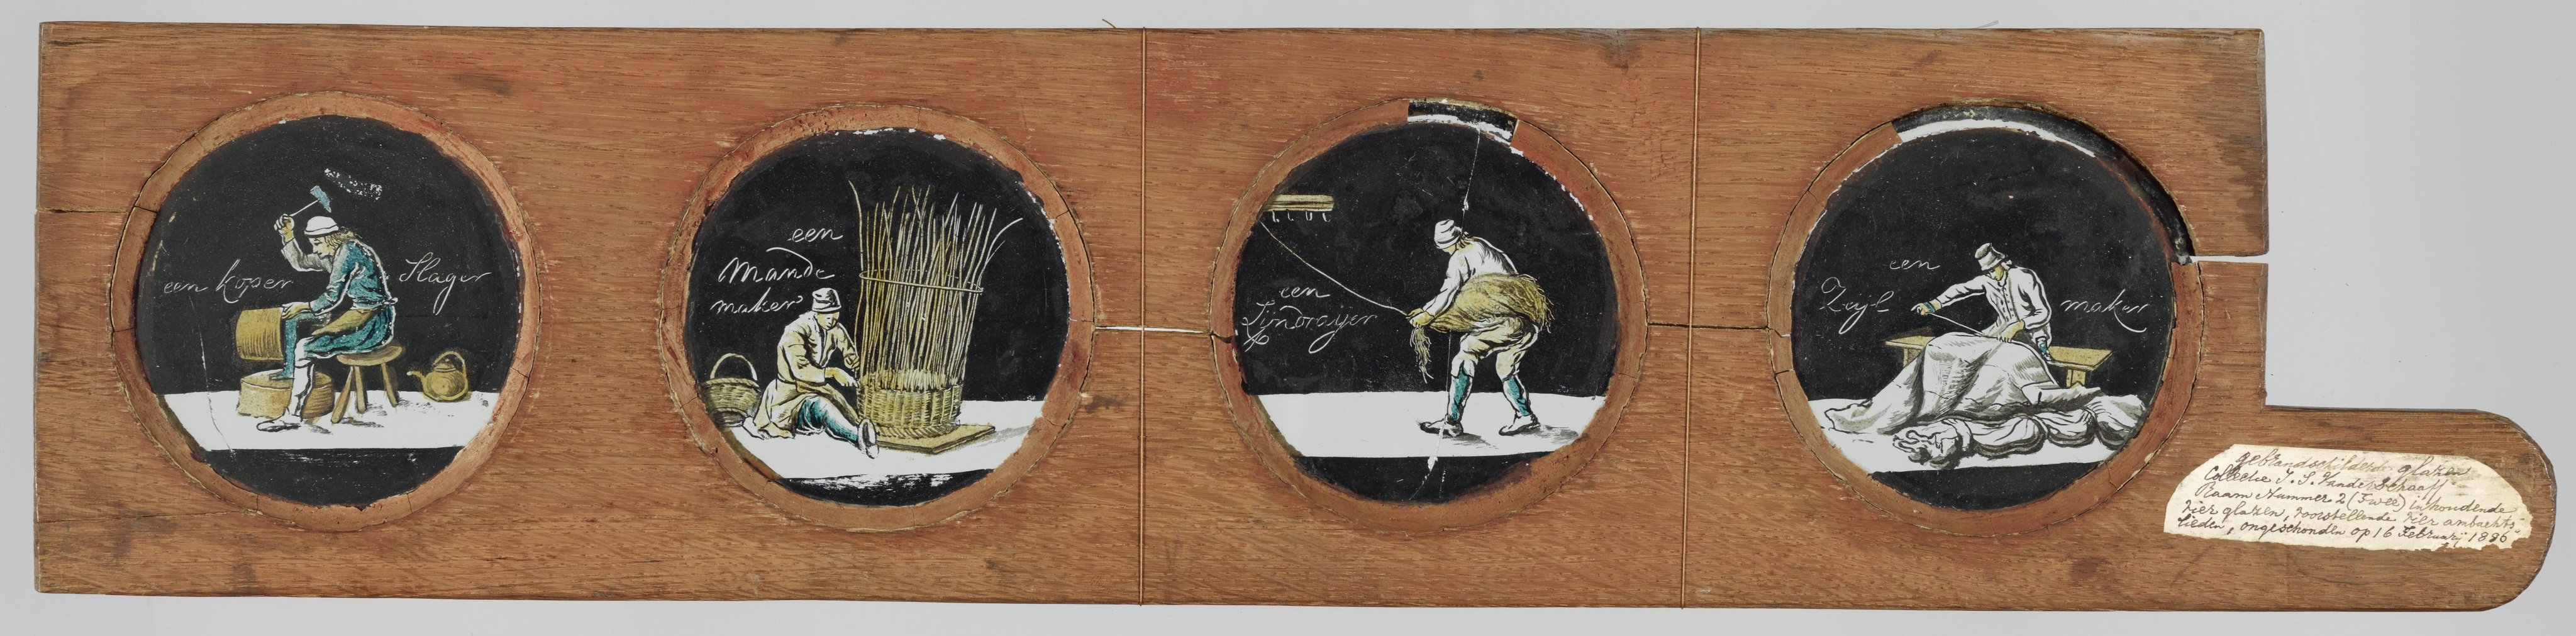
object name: lantern slide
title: Vier beroepen naar Het Menselyk Bedryf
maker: Anonymous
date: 1700-1790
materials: glass, wood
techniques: enamel painting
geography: netherlands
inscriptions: label: ‘'Gebrandschilderde glazen. Collectie I.S. van der Schaaff, Baarn. Nummer 2 (twee) inhoudende vier glazen, voorstellende vier ambachten, ongeschonden en heel op 18 februarij 1886.'’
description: Vier glazen in een houten vatting met handvat. Uiterst links: 'een koperslager', met geheven hamer, gezeten op een kruk. Rechts daarvan: 'een mandemaker', op de grond gezeten. Rechts daarvan: 'een lijndraijer', staande aan een lijnbaan. Uiterst rechts: 'een zeijlmaker', staande achter een tafel. Alle afbeeldingen tegen een zwarte achtergrond.